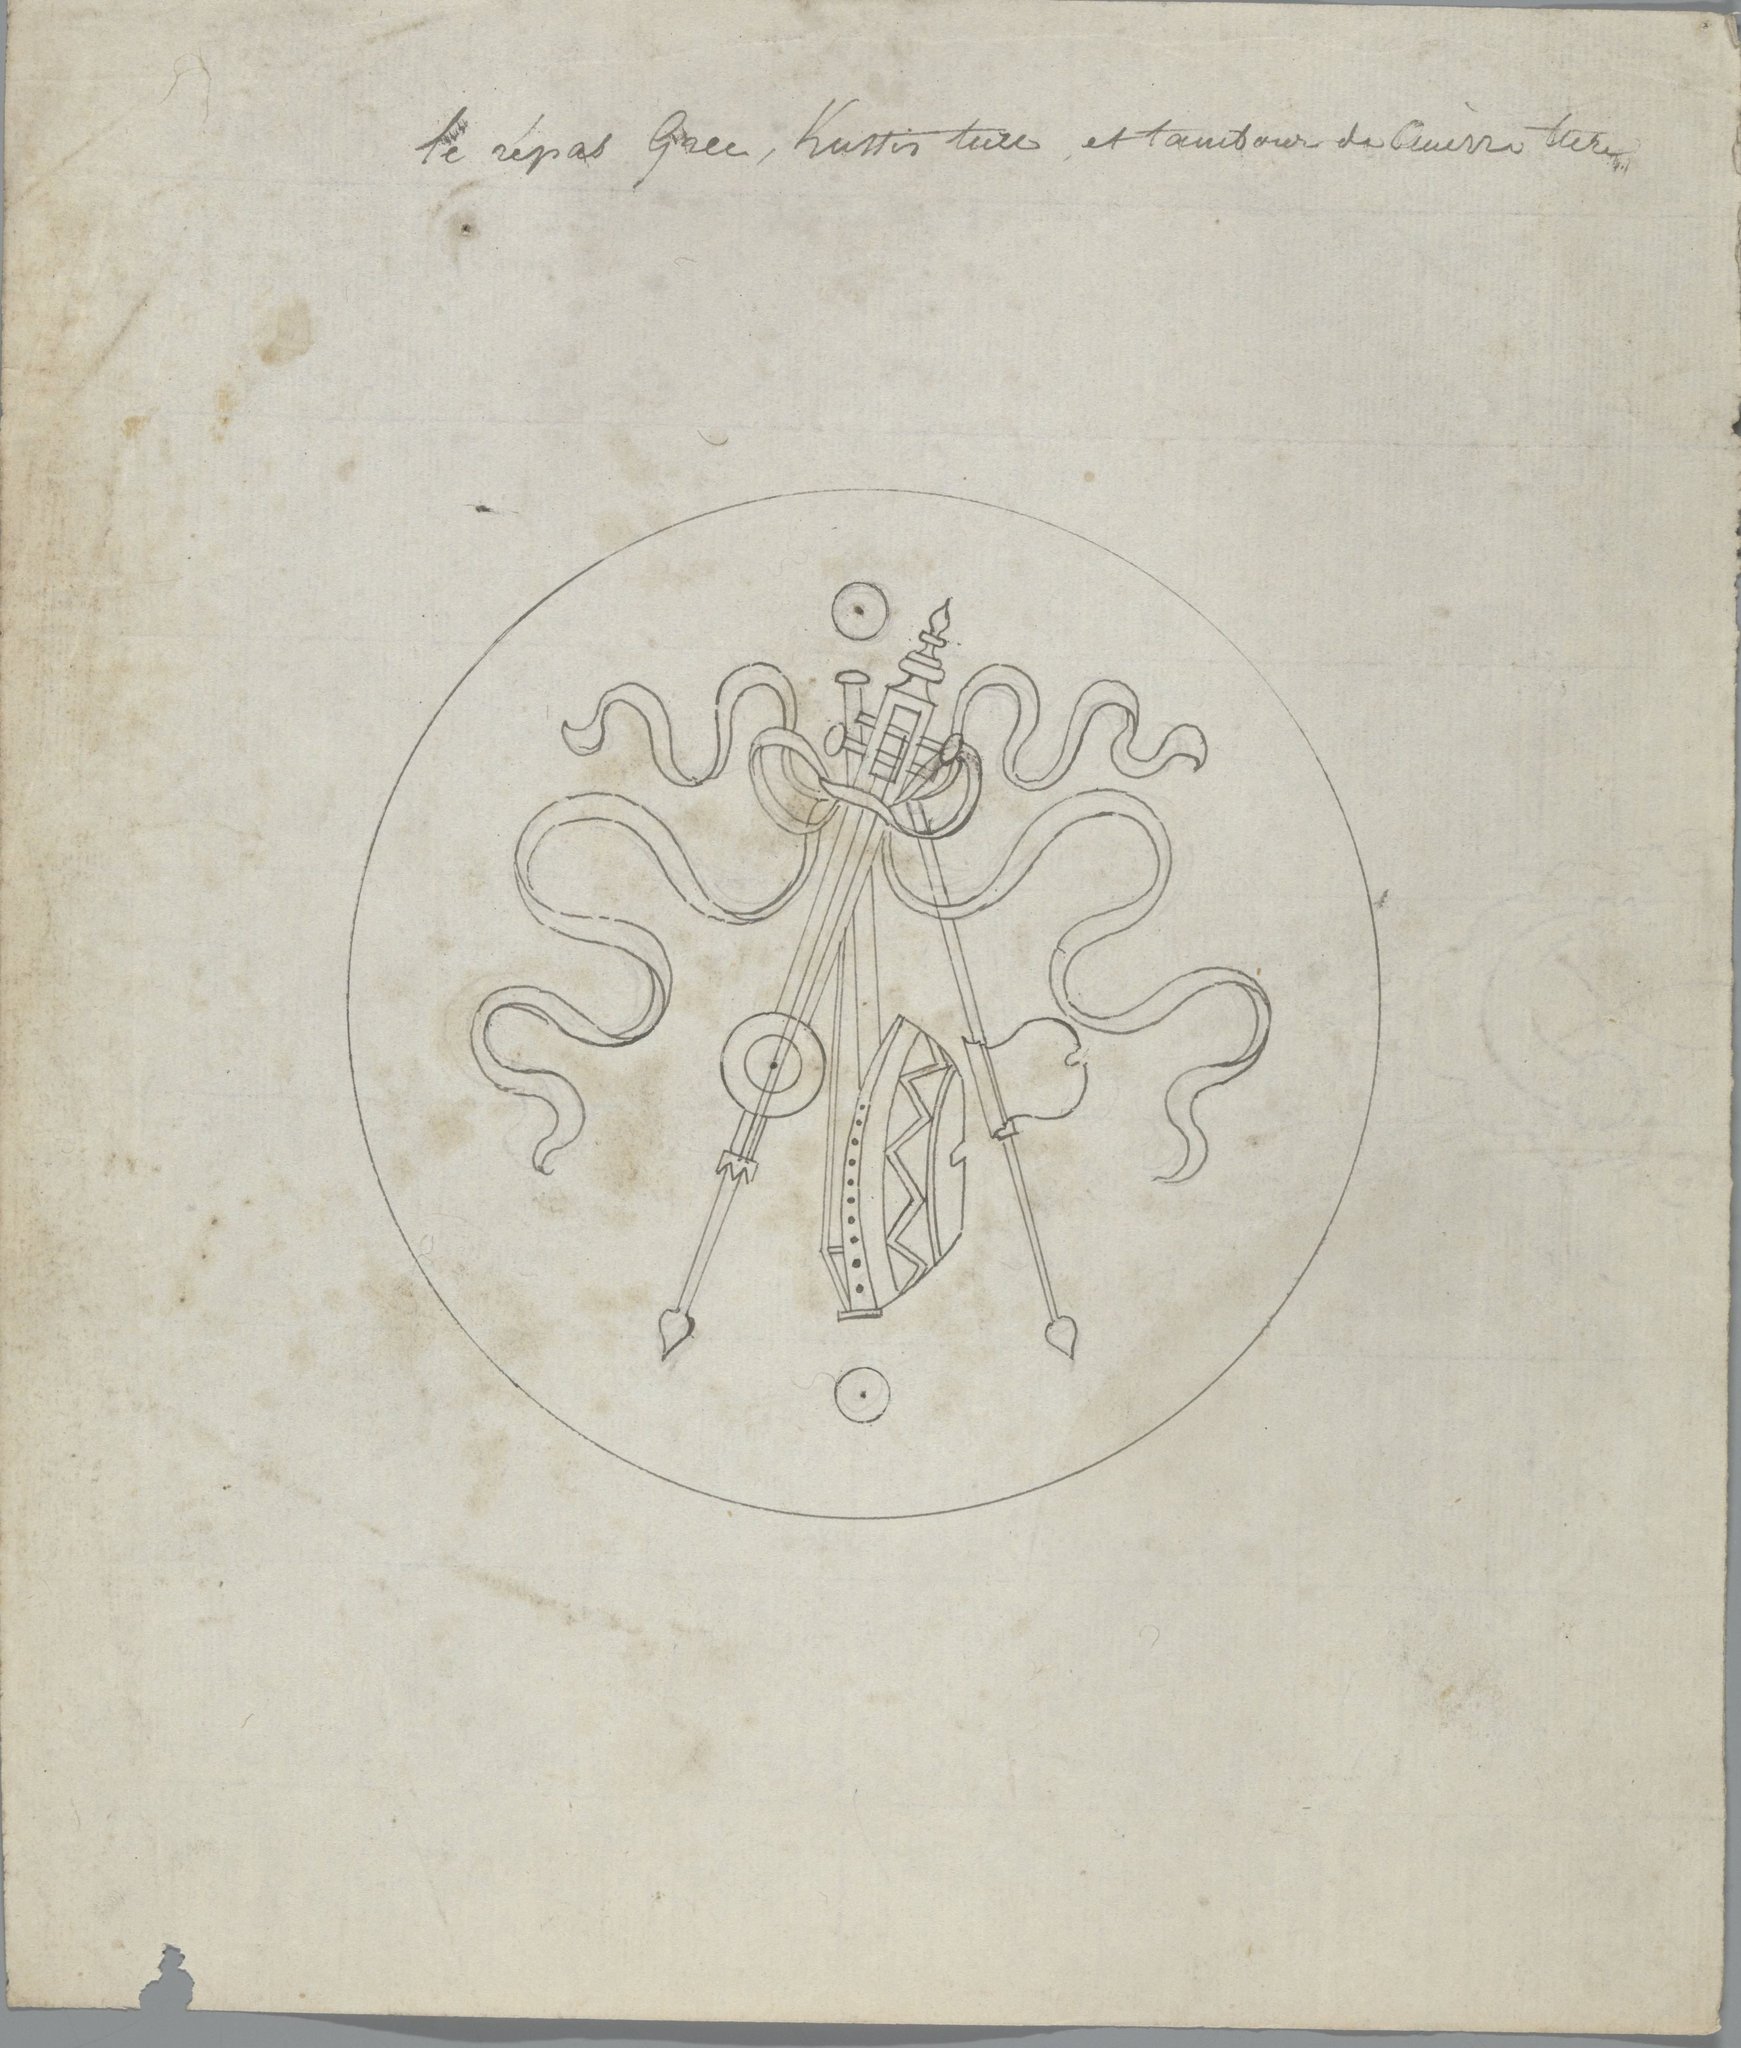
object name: design drawing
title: Ontwerp voor marqueterie van aan linten opgehangen muziekinstrument(en) in rond medaillon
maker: pierre félix van doren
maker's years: 1797-1856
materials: graphite, ink, paper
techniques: pen in black ink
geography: brussels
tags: musical instruments; group of musical instruments, trophy, i.e.: decorative arrangement of symbolic or typical objects ~ ornament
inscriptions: inscription: ‘le repas[?] Grec, Kuttis [?] turc et tambour de Guerre turc’, watermark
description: Een van 103 ontwerpen voor marqueterie van aan linten opgehangen muziekinstrumenten in ronde medaillons, bestemd voor de set stoelen gemaakt door Van Doren voor de grote zaal van het Paleis van de Prins van Oranje in Brussel in 1828.